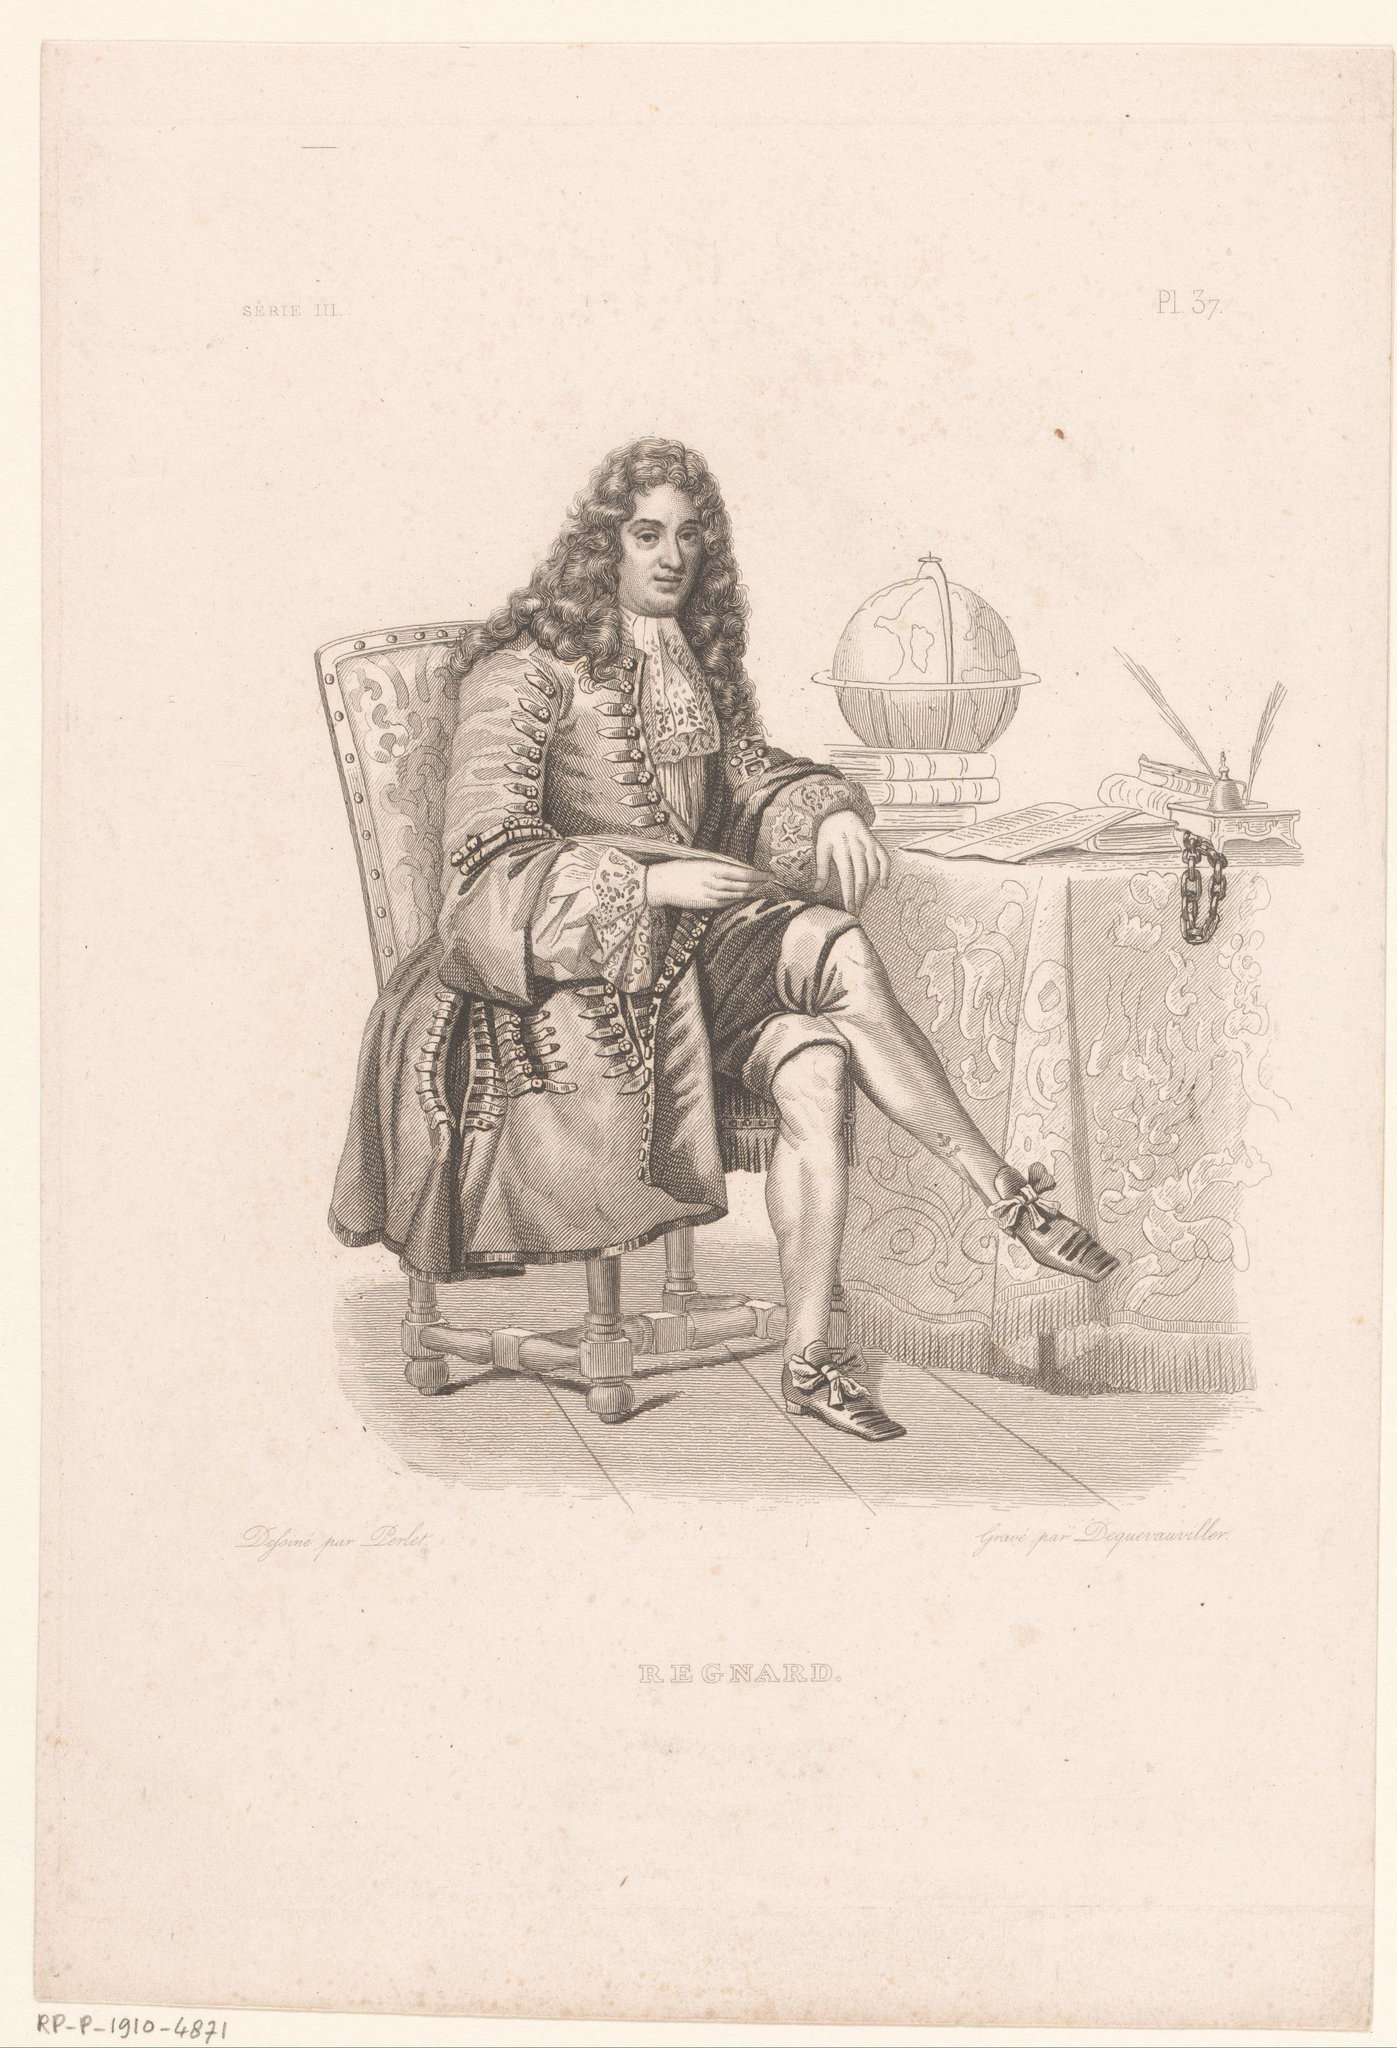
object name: print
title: Portret van Jean-François Regnard aan een tafel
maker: françois jacques dequevauviller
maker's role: print maker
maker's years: 1783-1848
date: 1793-1848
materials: paper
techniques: engraving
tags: paris, historical persons, portrait of a writer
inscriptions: collector's mark: Lugt 2228